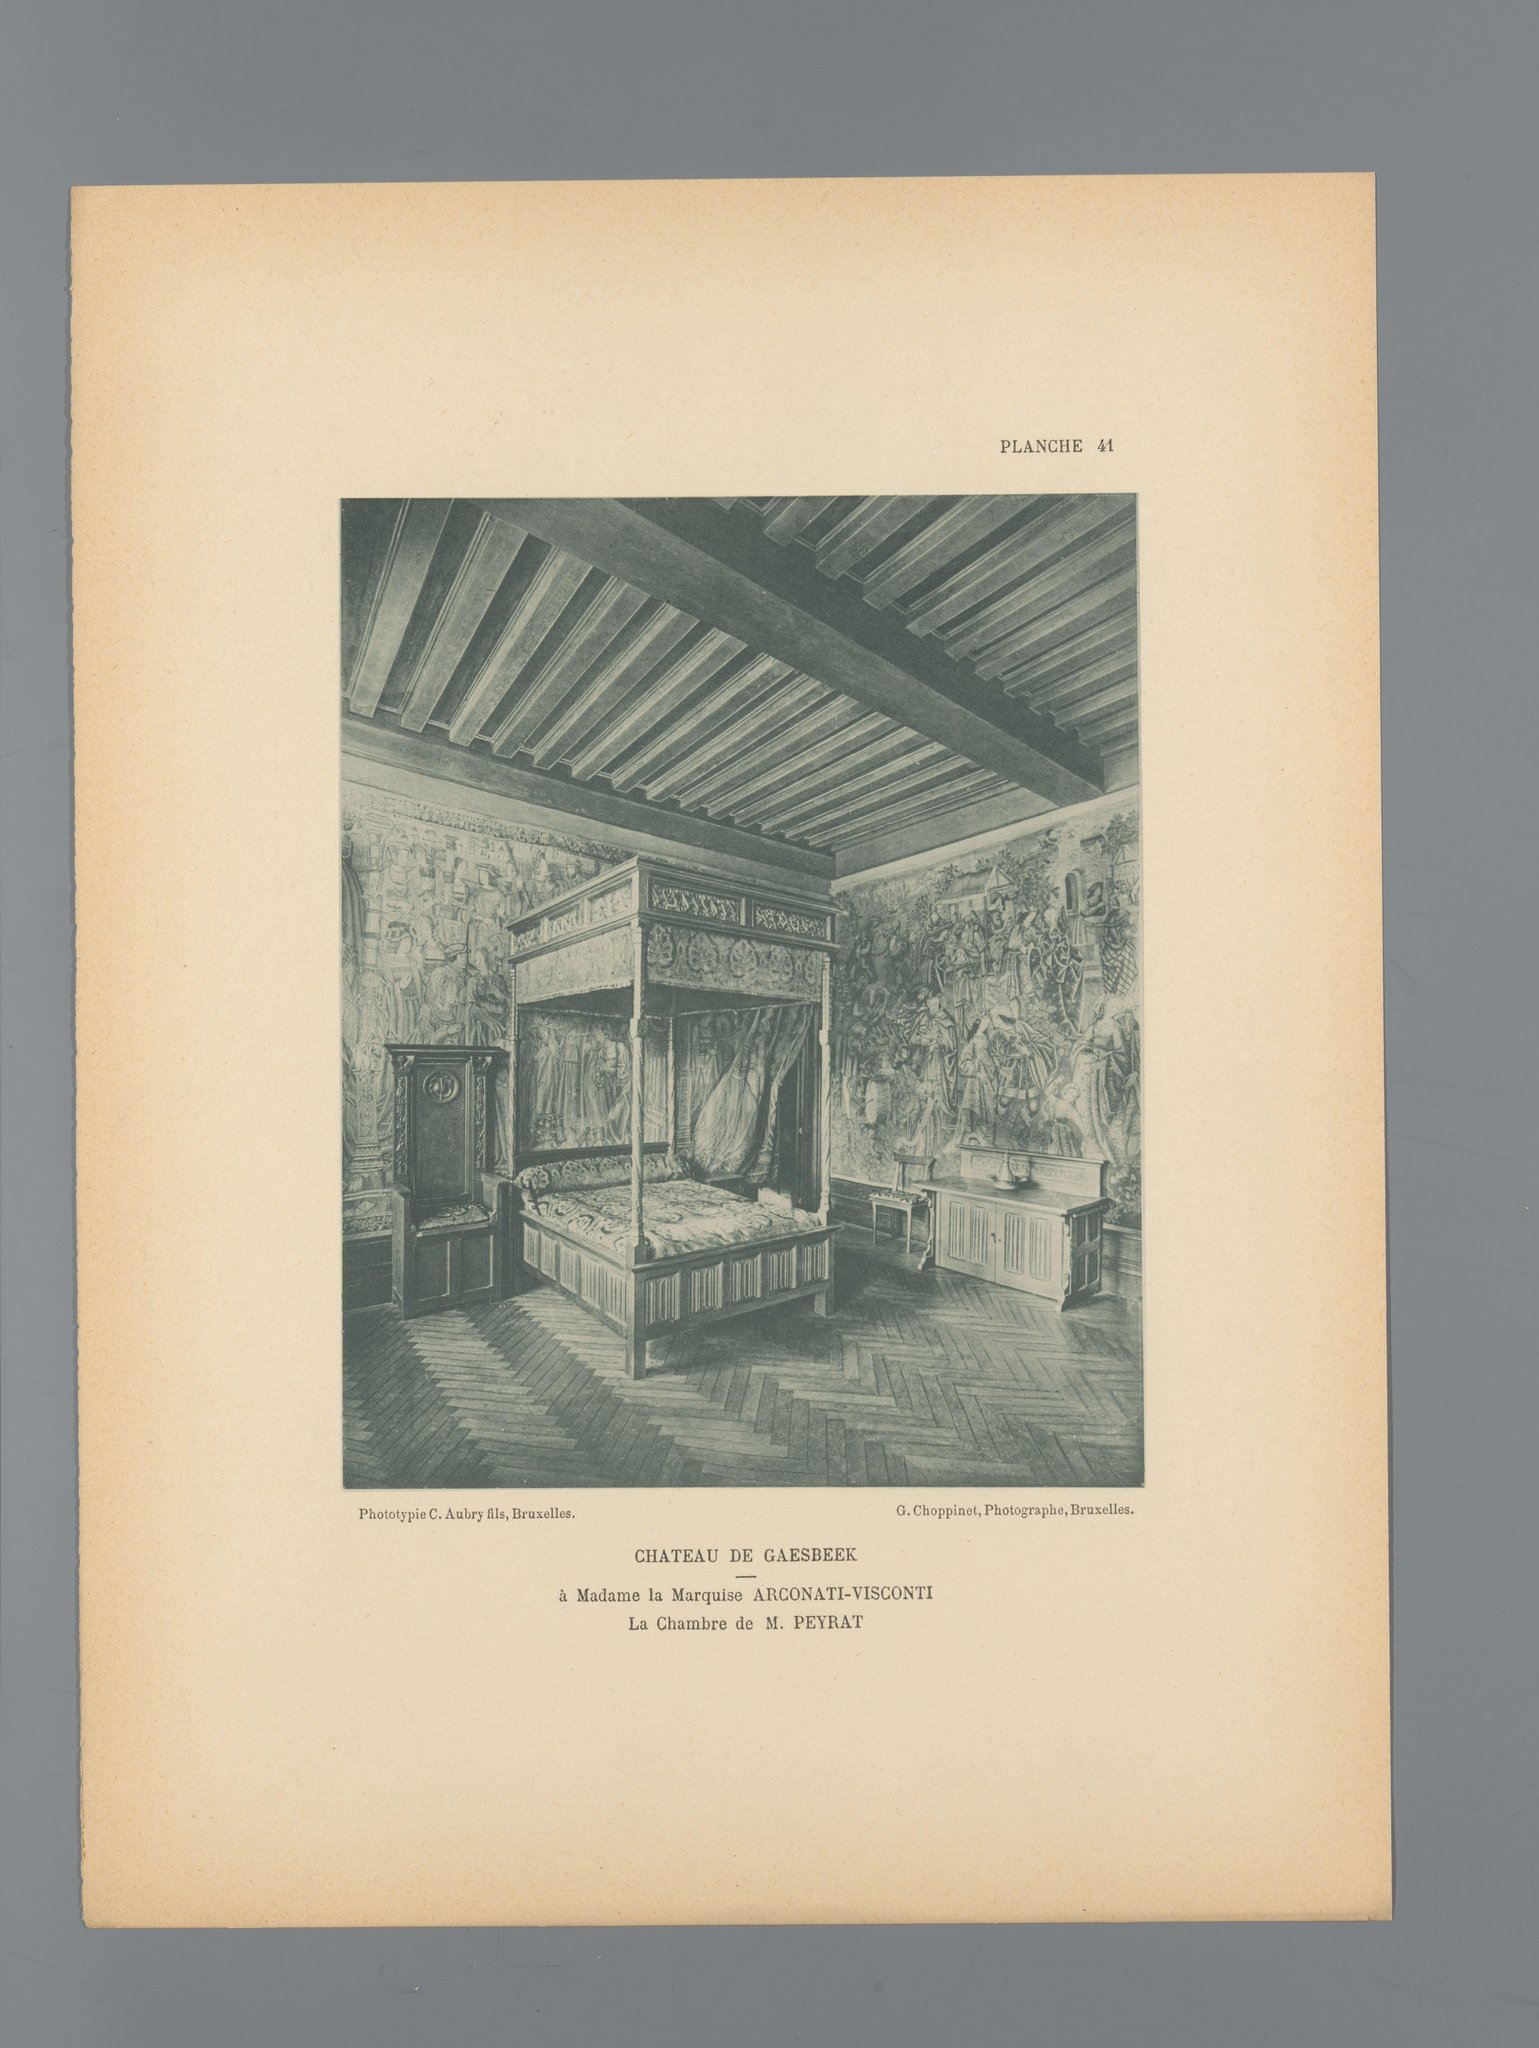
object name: photomechanical print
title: Chateau de Gaesbeek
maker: gustave choppinet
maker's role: fotograaf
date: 1893-1898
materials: paper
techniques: photograph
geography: brussels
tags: castle, bedroom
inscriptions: number: ‘PLANCHE 41’, inscription: ‘à Madame la Marquise ARCONATI-VISCONTI/ La Chambre de M. PEYRAT’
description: Deze prent maakt deel uit van een omslag met 89 prenten en 5 tekstbladen.